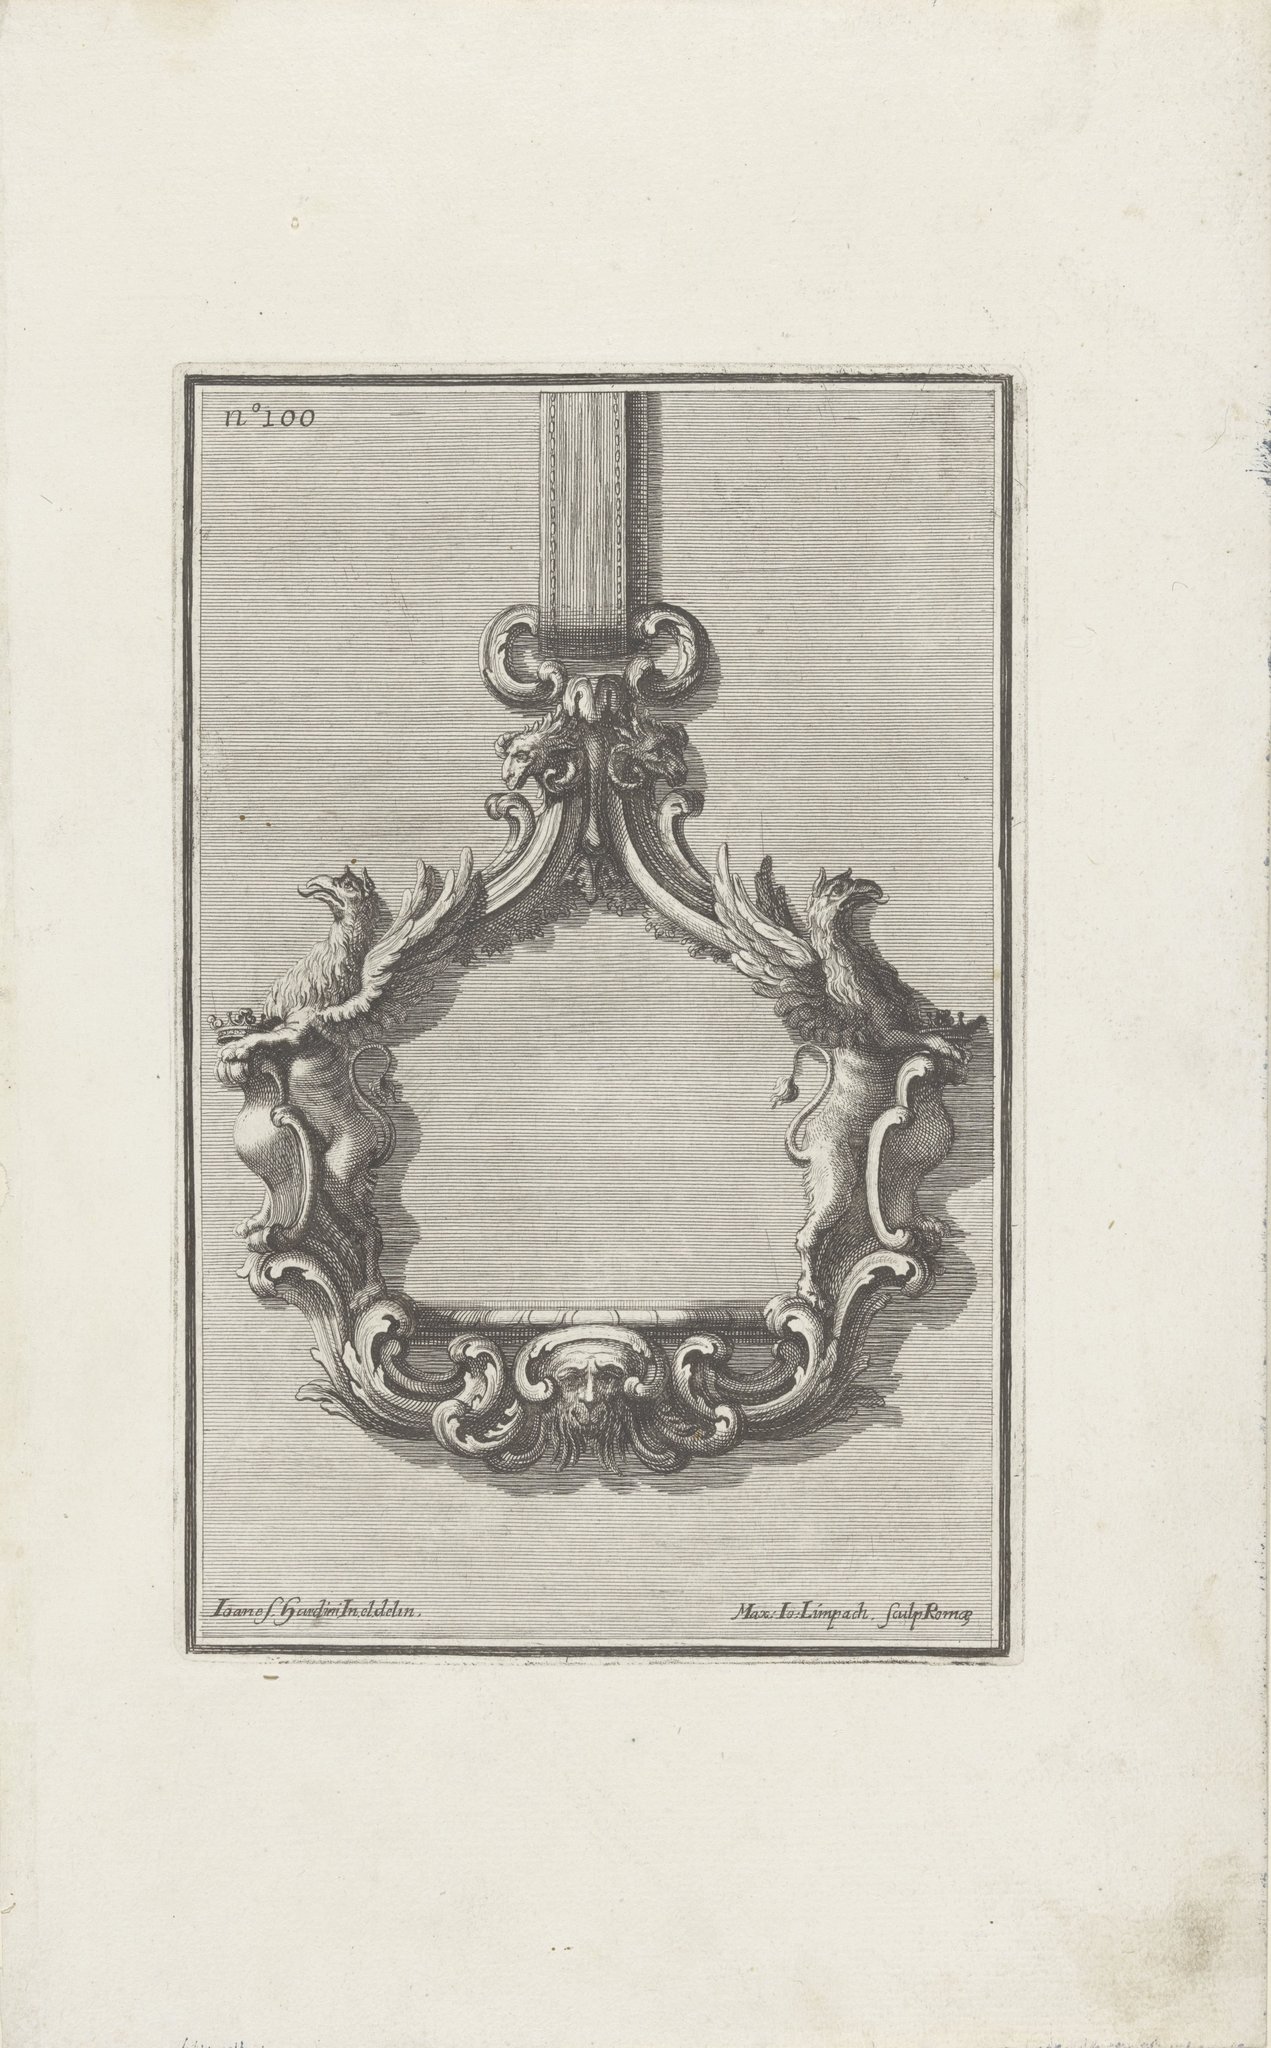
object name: ornament print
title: Diverse kerkelijke voorwerpen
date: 1714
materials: paper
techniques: etching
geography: rome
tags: clemens xi, griffin (lion/eagle); 'griffo' (ripa), ornaments ~ art, ram's head ~ ornament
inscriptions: collector's mark: Lugt 2228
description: Prent maakt deel uit van een reeks van 100 ornamentprenten naar ontwerp van Giovanni Giardini.